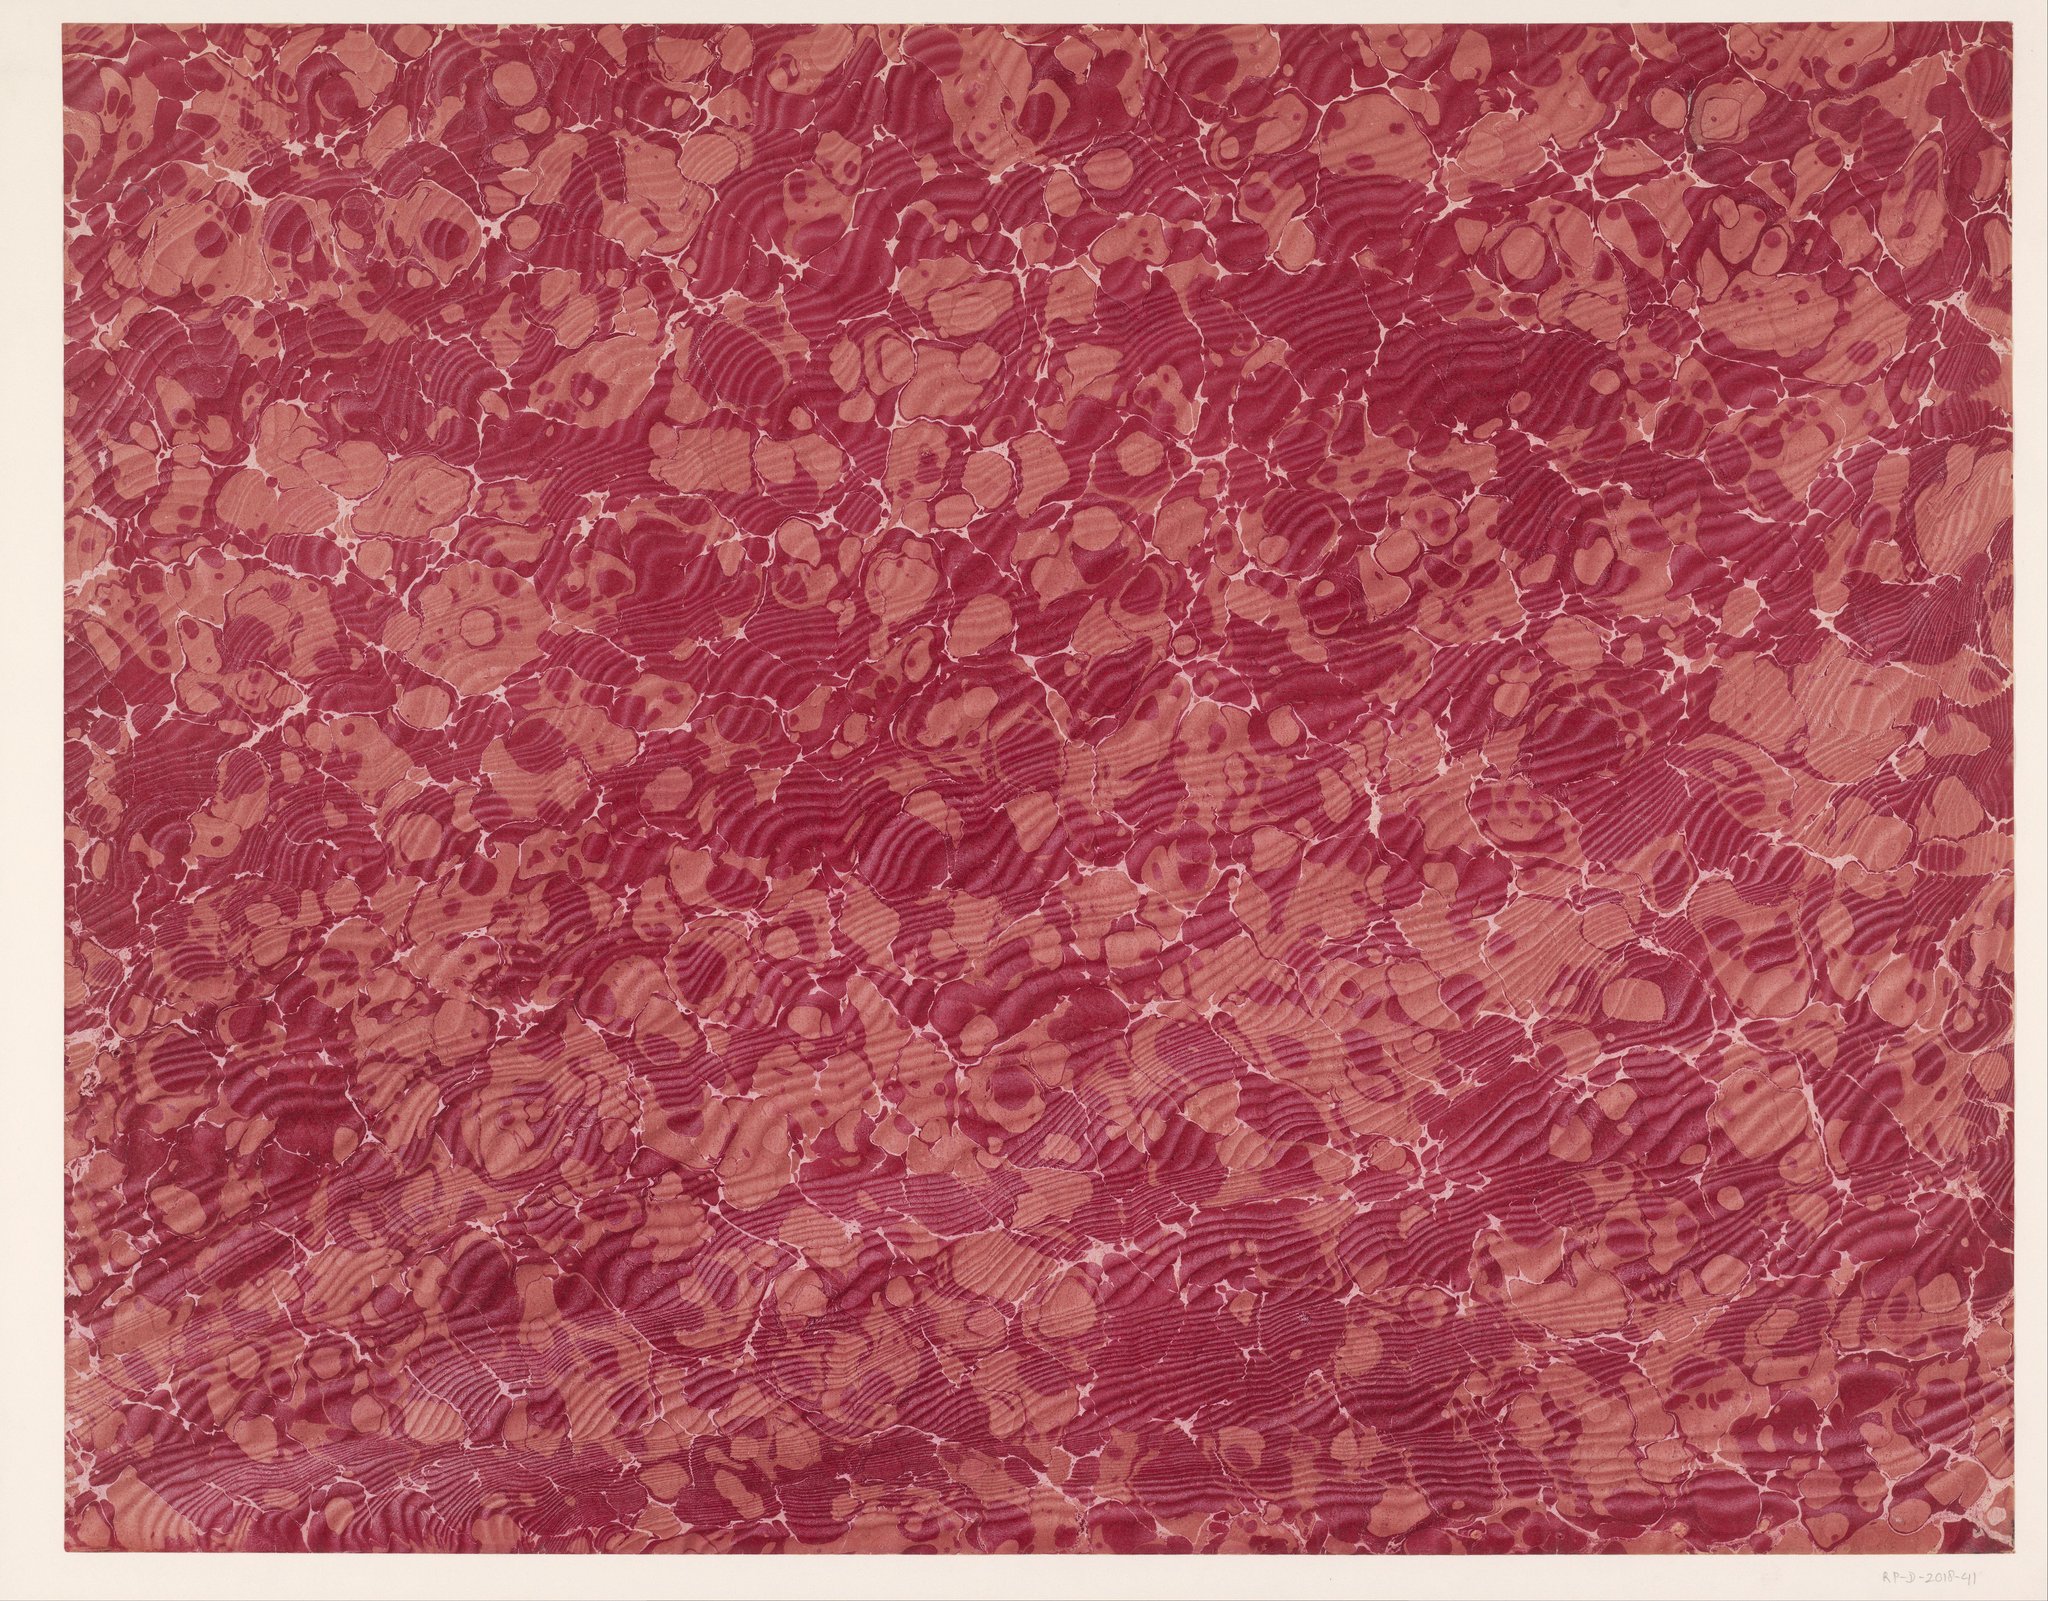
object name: marbled paper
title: Moirémarmer in rood en roze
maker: Anonymous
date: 1900-2000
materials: lacquer, paint, paper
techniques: marbling